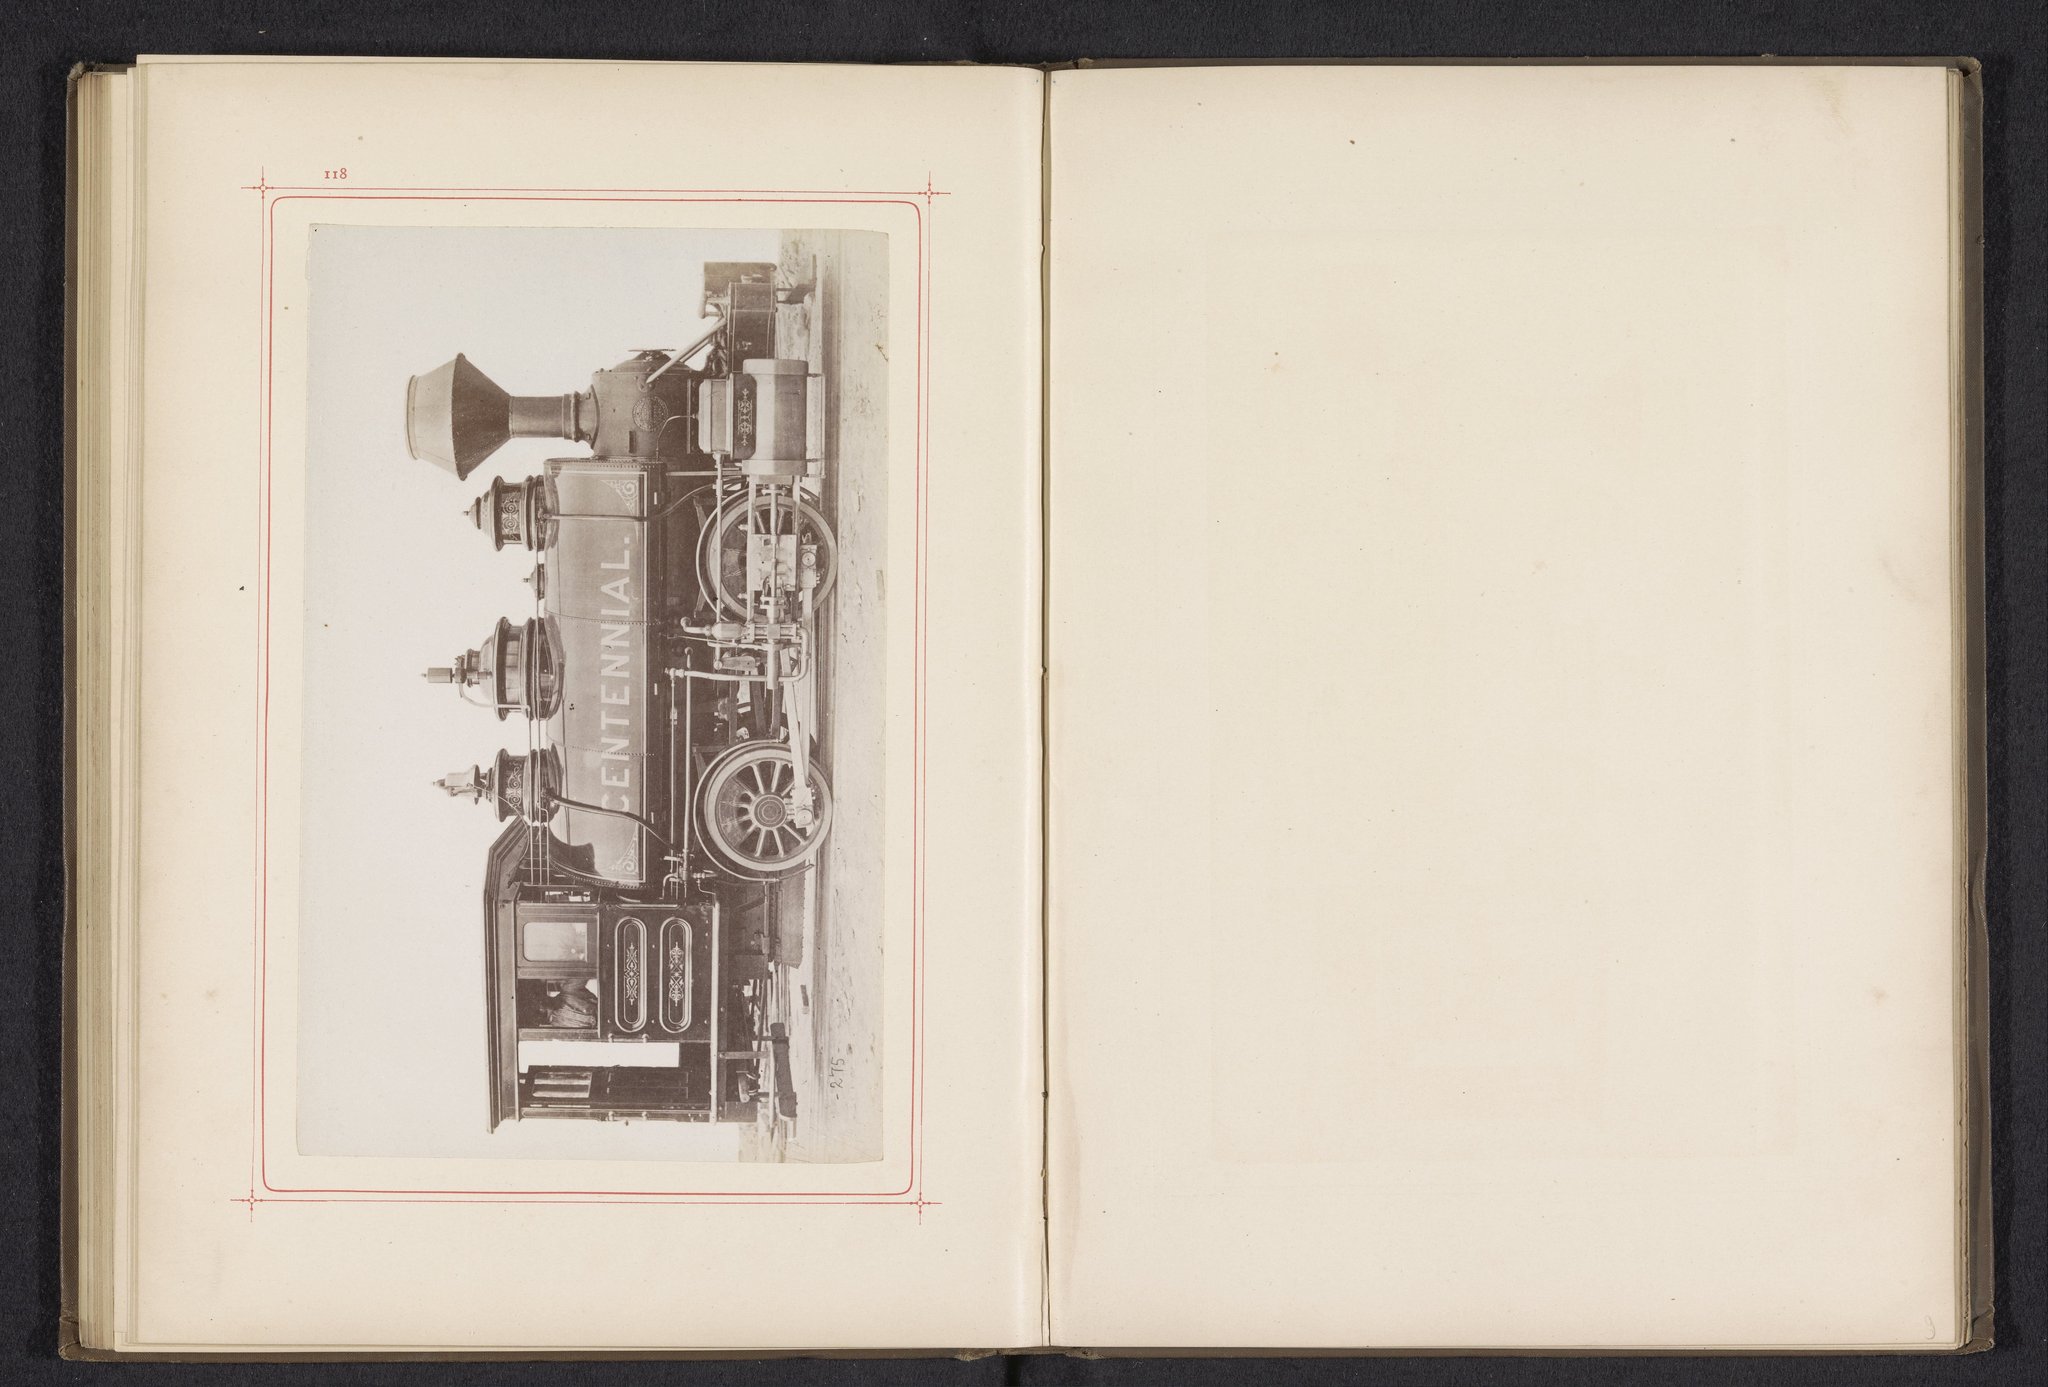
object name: page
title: Amerikaanse stoomlocomotief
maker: Anonymous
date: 1871-1881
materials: photographic support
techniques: albumen print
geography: united states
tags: steam locomotive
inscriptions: number: ‘275’